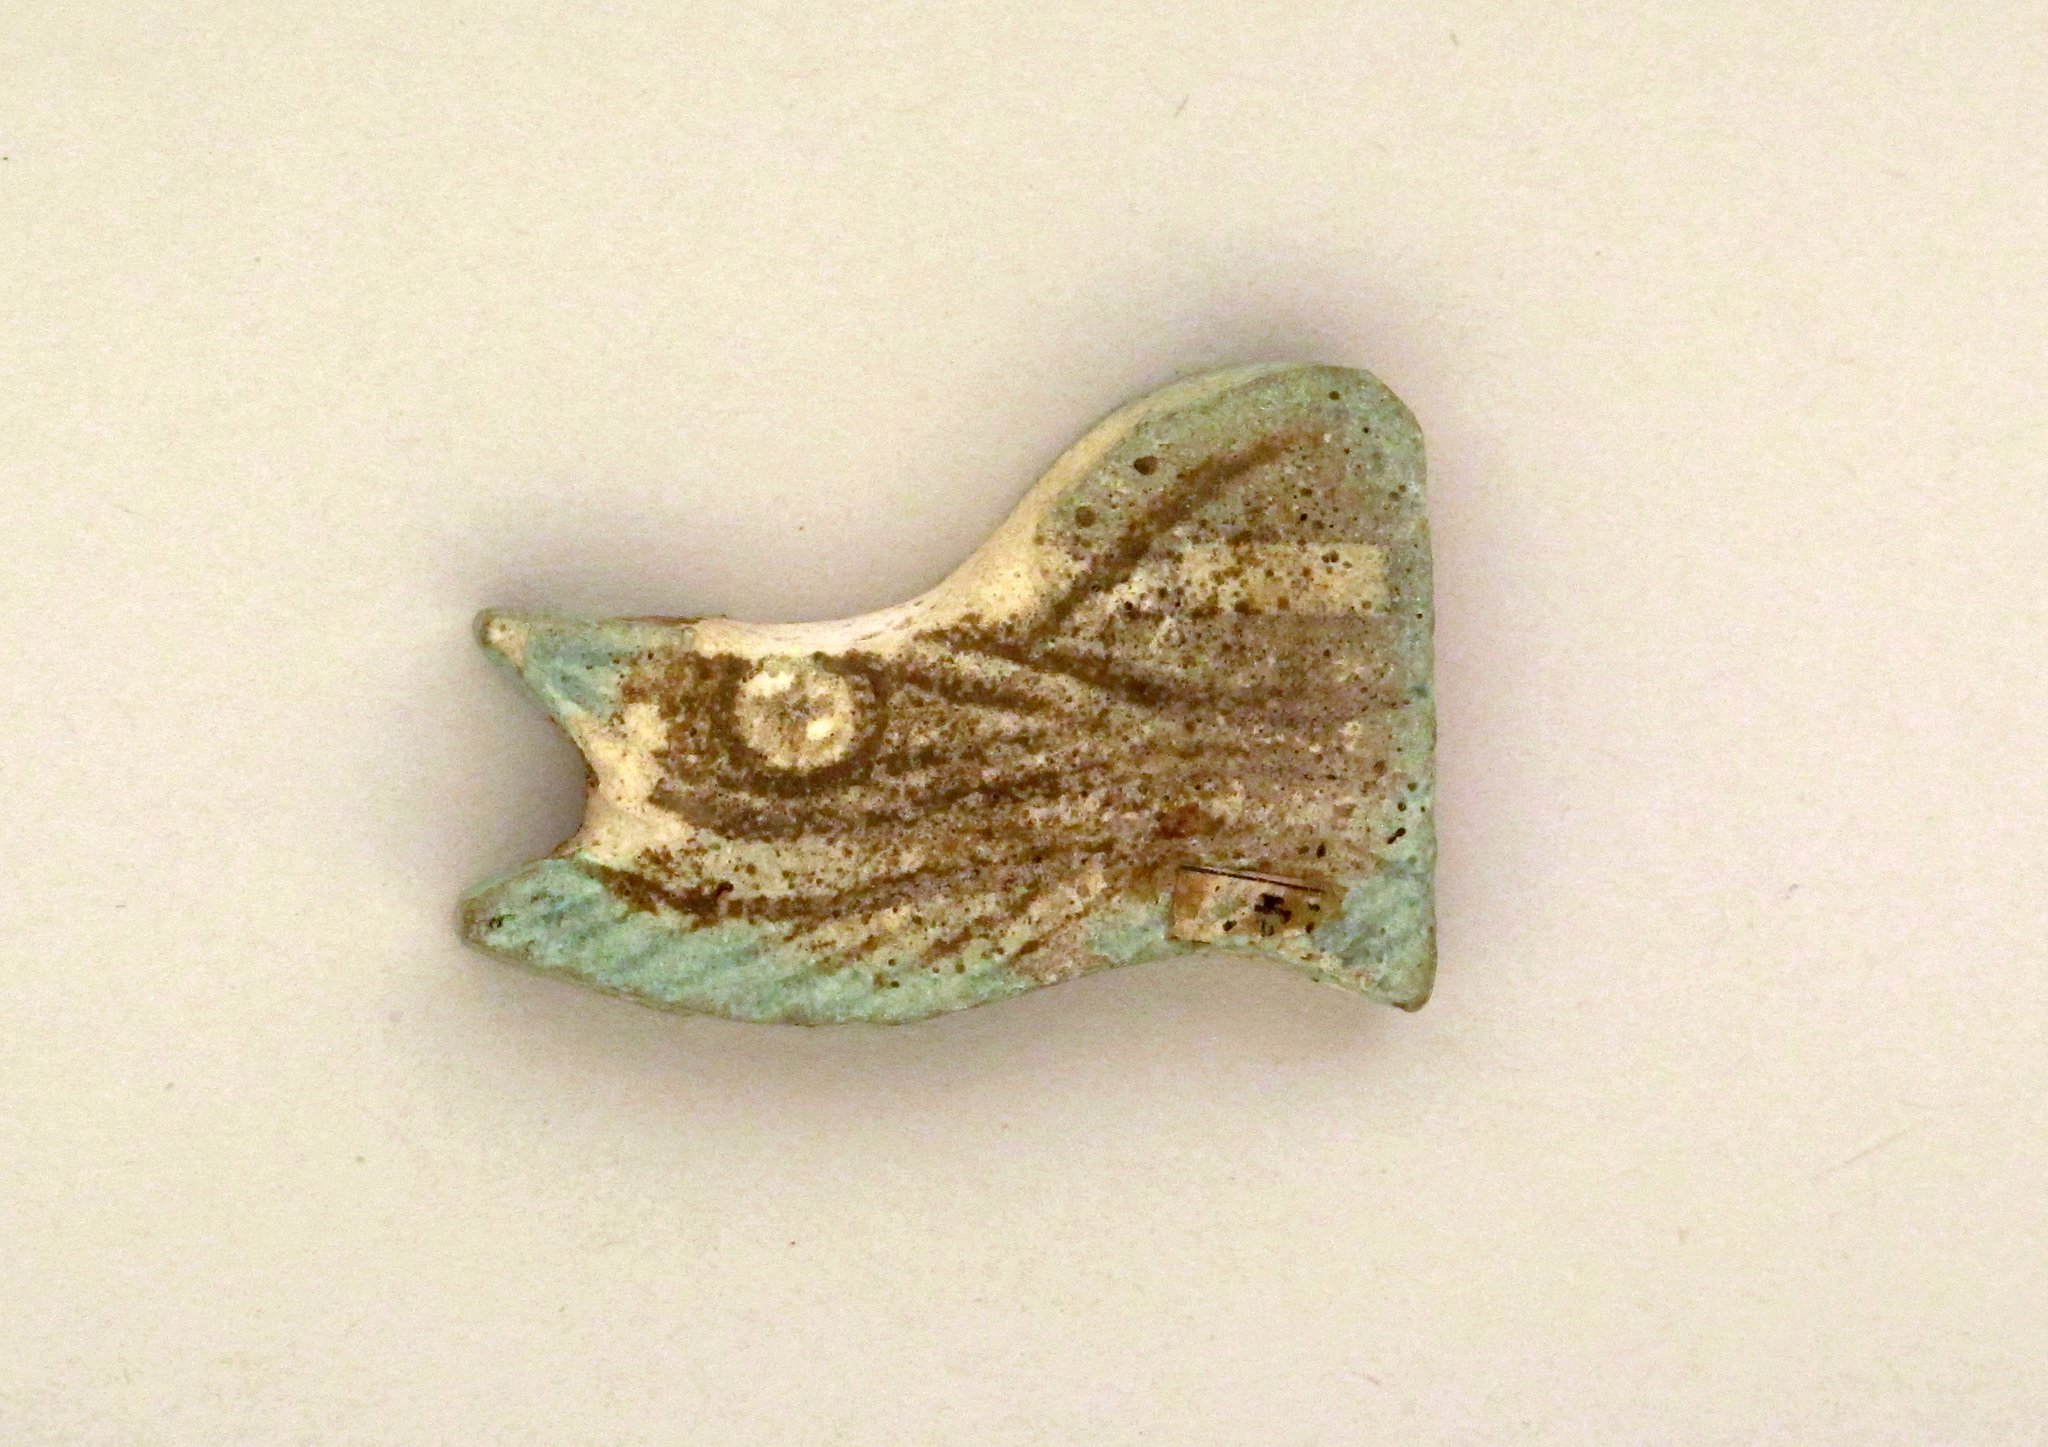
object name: amulet, eye, udjat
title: Faience Udjat eye amulet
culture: egyptian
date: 664-334 BCE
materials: faience